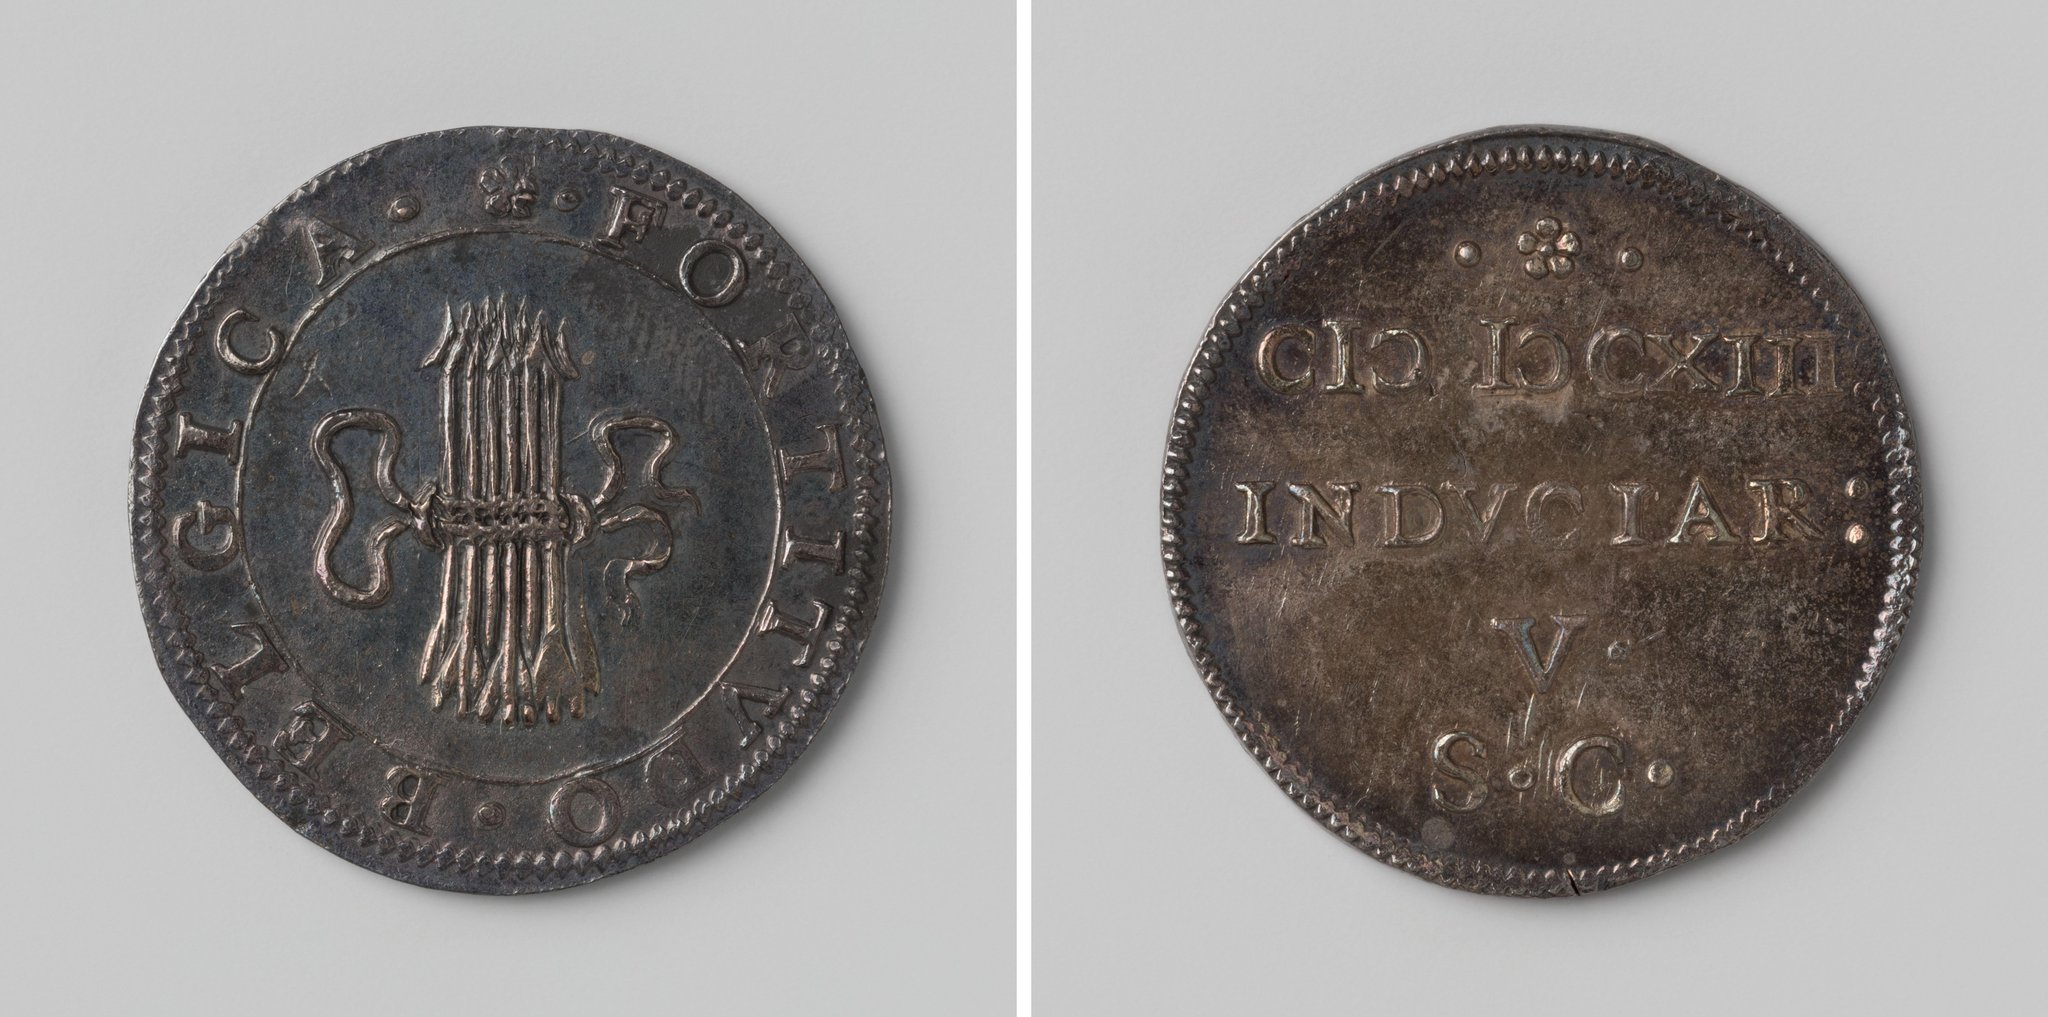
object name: jeton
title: Macht van de Zeven Verenigde Nederlanden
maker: Anonymous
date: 1613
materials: silver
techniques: striking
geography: dordrecht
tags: netherlands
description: Zilveren penning. Voorzijde: bundel van zee met lint samengebonden pijlen binnen omschrift. Keerzijde: opschrift